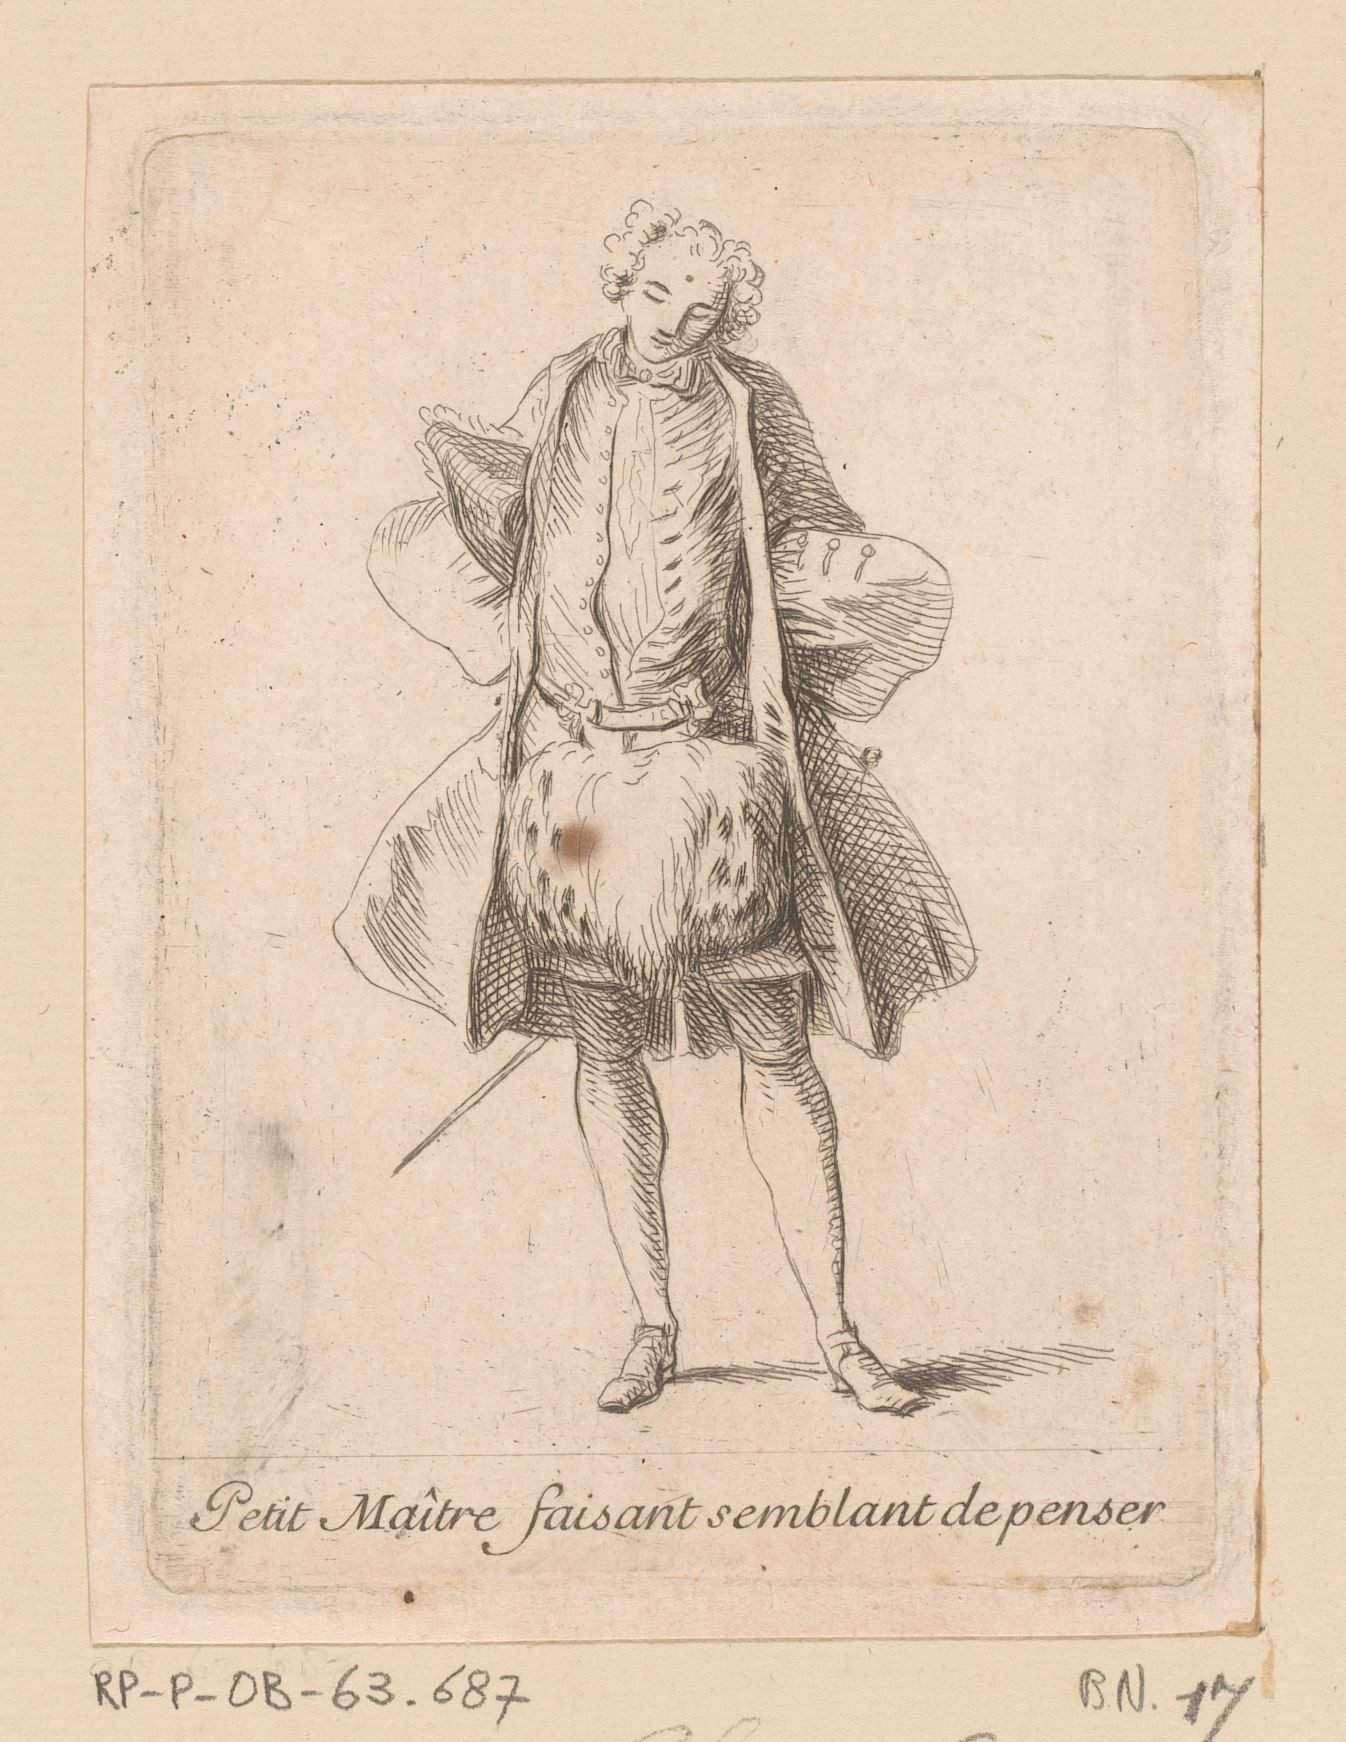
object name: print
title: Staande edelman van voren gezien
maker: charles-antoine coypel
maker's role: painter, print maker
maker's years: 1694-1752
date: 1704-1752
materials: paper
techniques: etching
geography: france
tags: clothes, costume (+ men's clothes)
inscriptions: collector's mark: Lugt 240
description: Maakt deel uit van een vierdelige serie getiteld: Figures de modes.